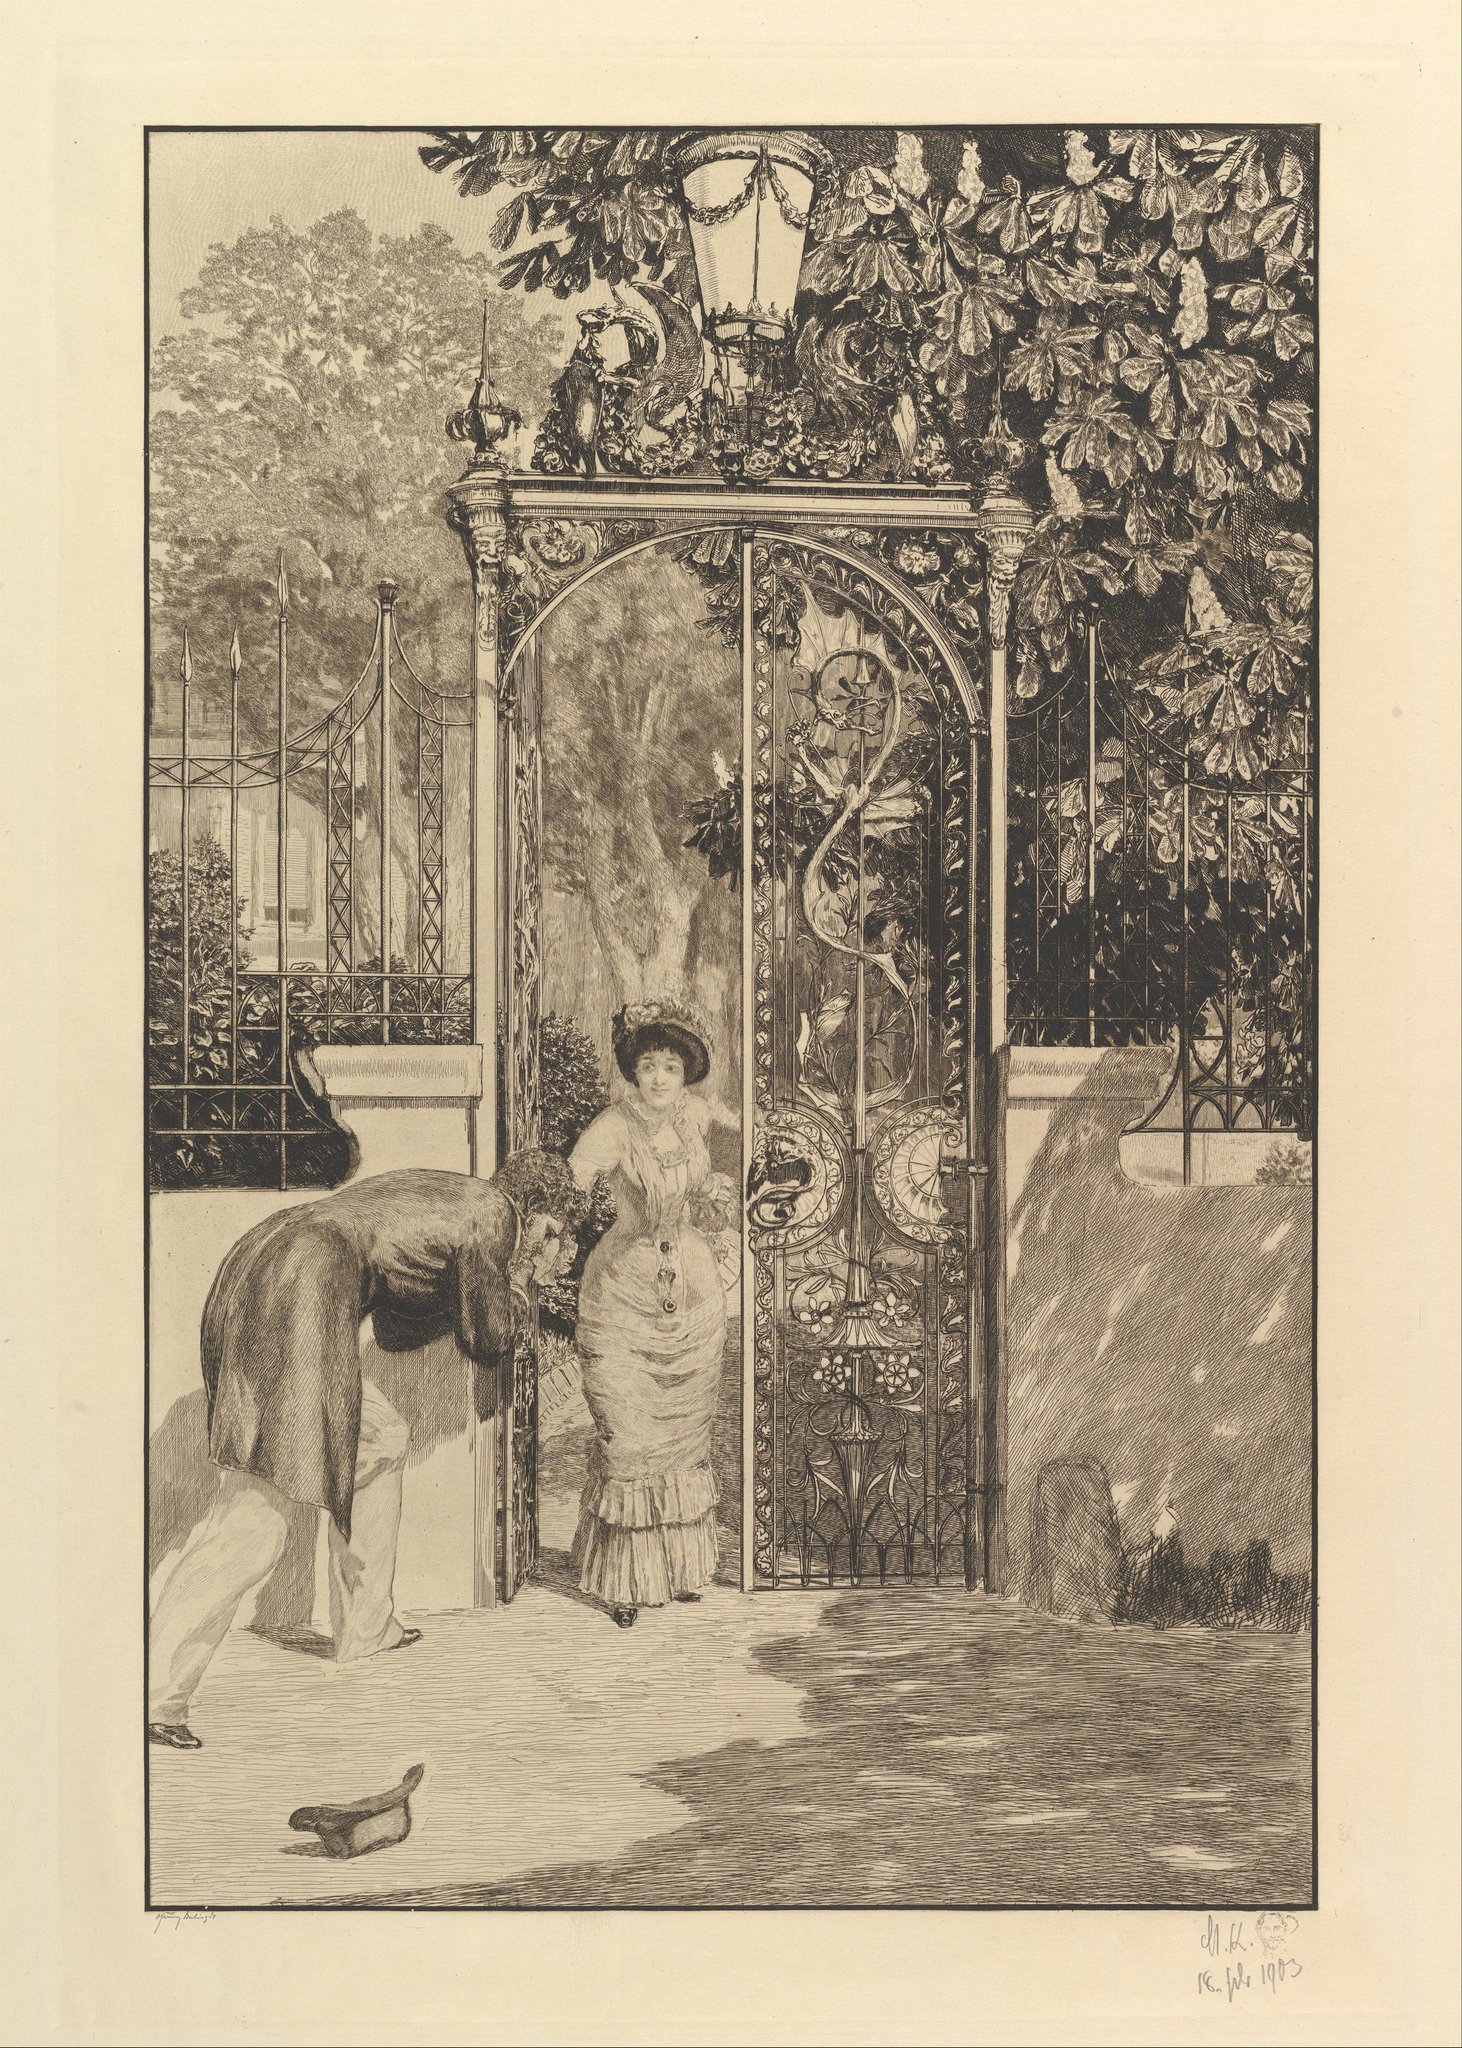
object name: print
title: At the Gate (from the series A Love)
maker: max klinger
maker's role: artist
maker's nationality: german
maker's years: 1857-1920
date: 1887-1903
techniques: etching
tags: gates,couples,men,women